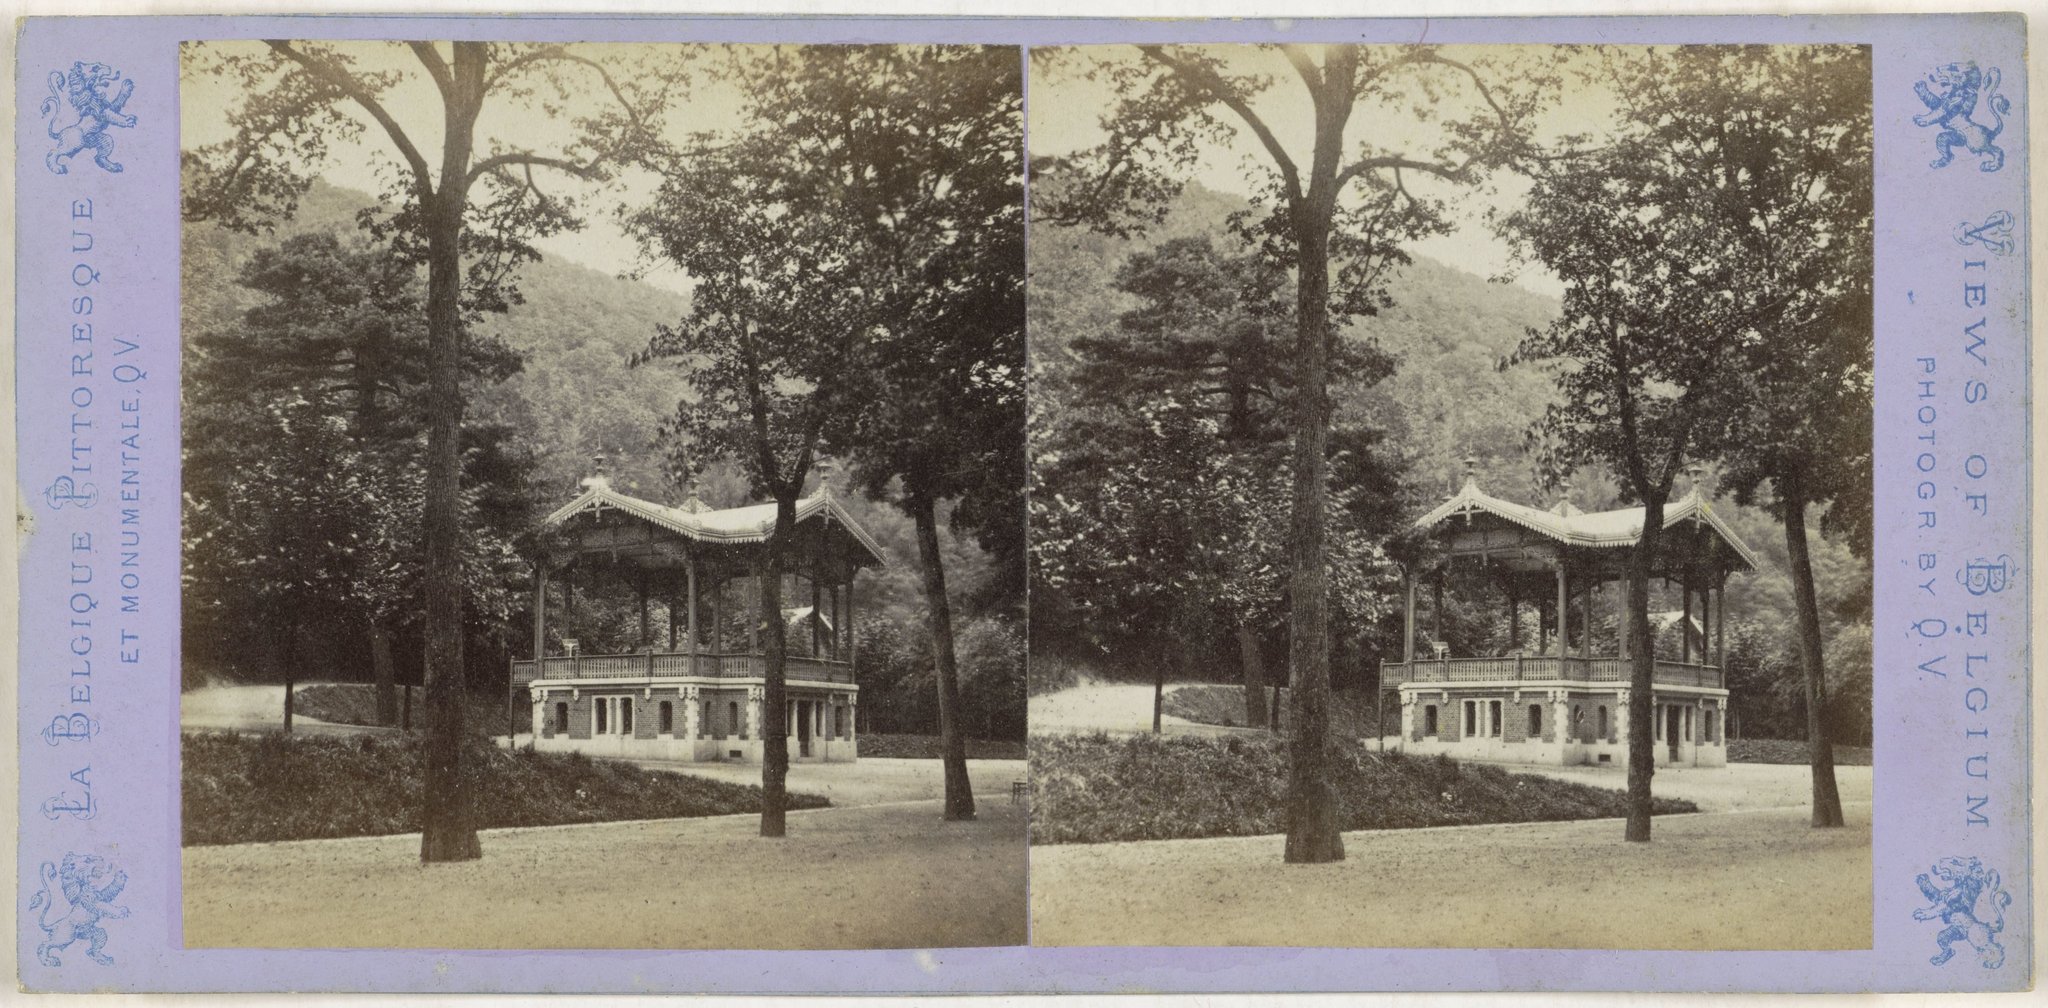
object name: stereograph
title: Gezicht op een muziekkoepel in het Parc de Sept Heures in Spa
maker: jules hippolyte quéval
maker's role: publisher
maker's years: 1824-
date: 1866-1870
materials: cardboard, paper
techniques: albumen print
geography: spa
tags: bandstand, public gardens, park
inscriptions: number: ‘No1778’